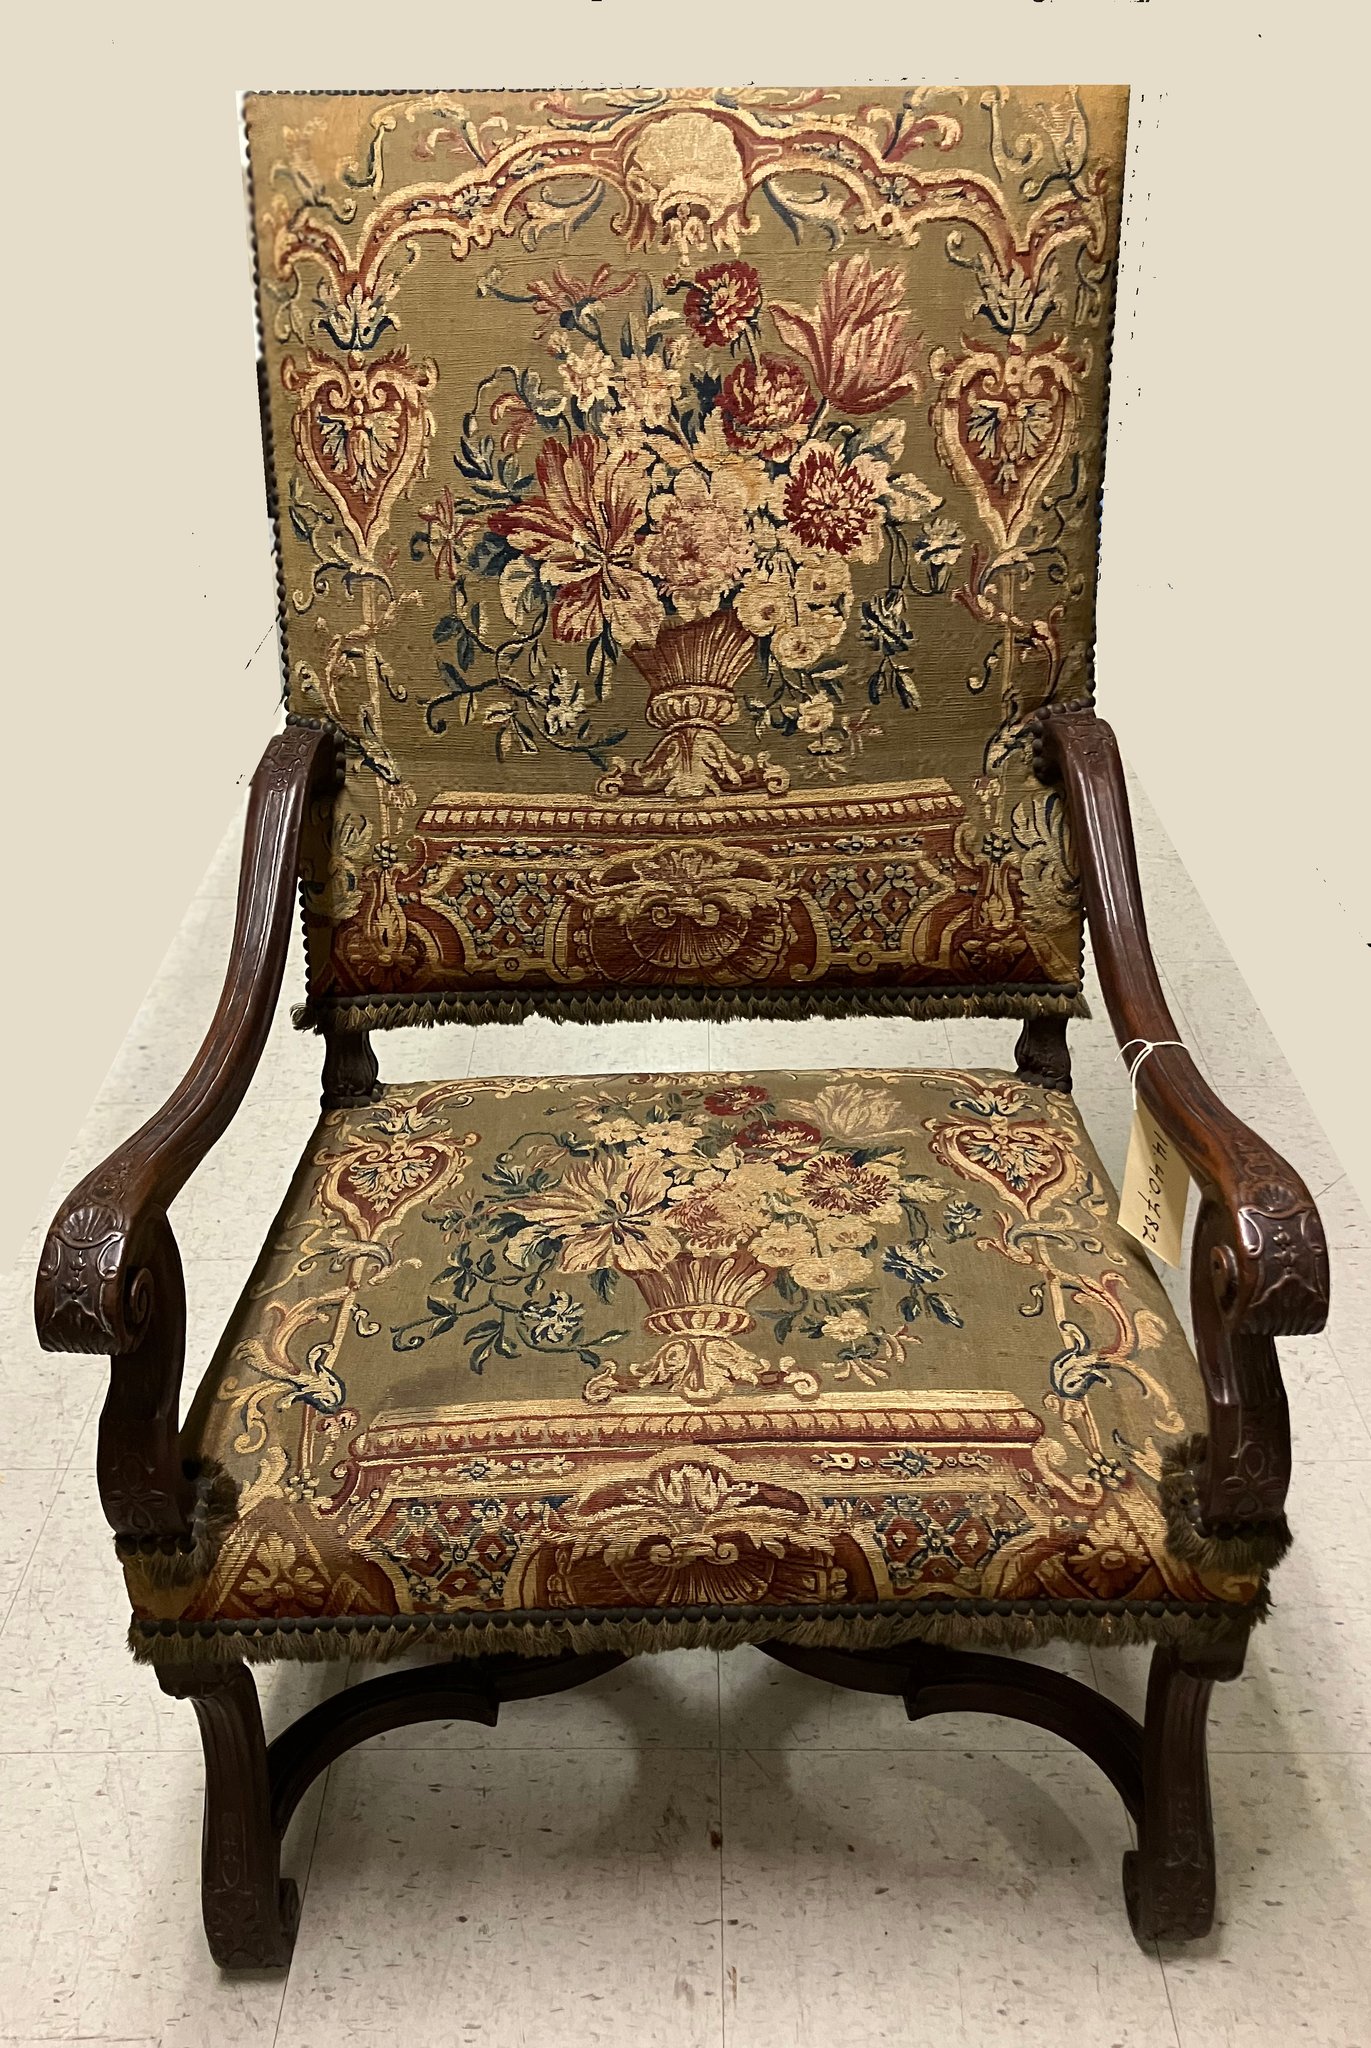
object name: armchair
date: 1651-1700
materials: silk, wood, wool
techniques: carving, tapestry